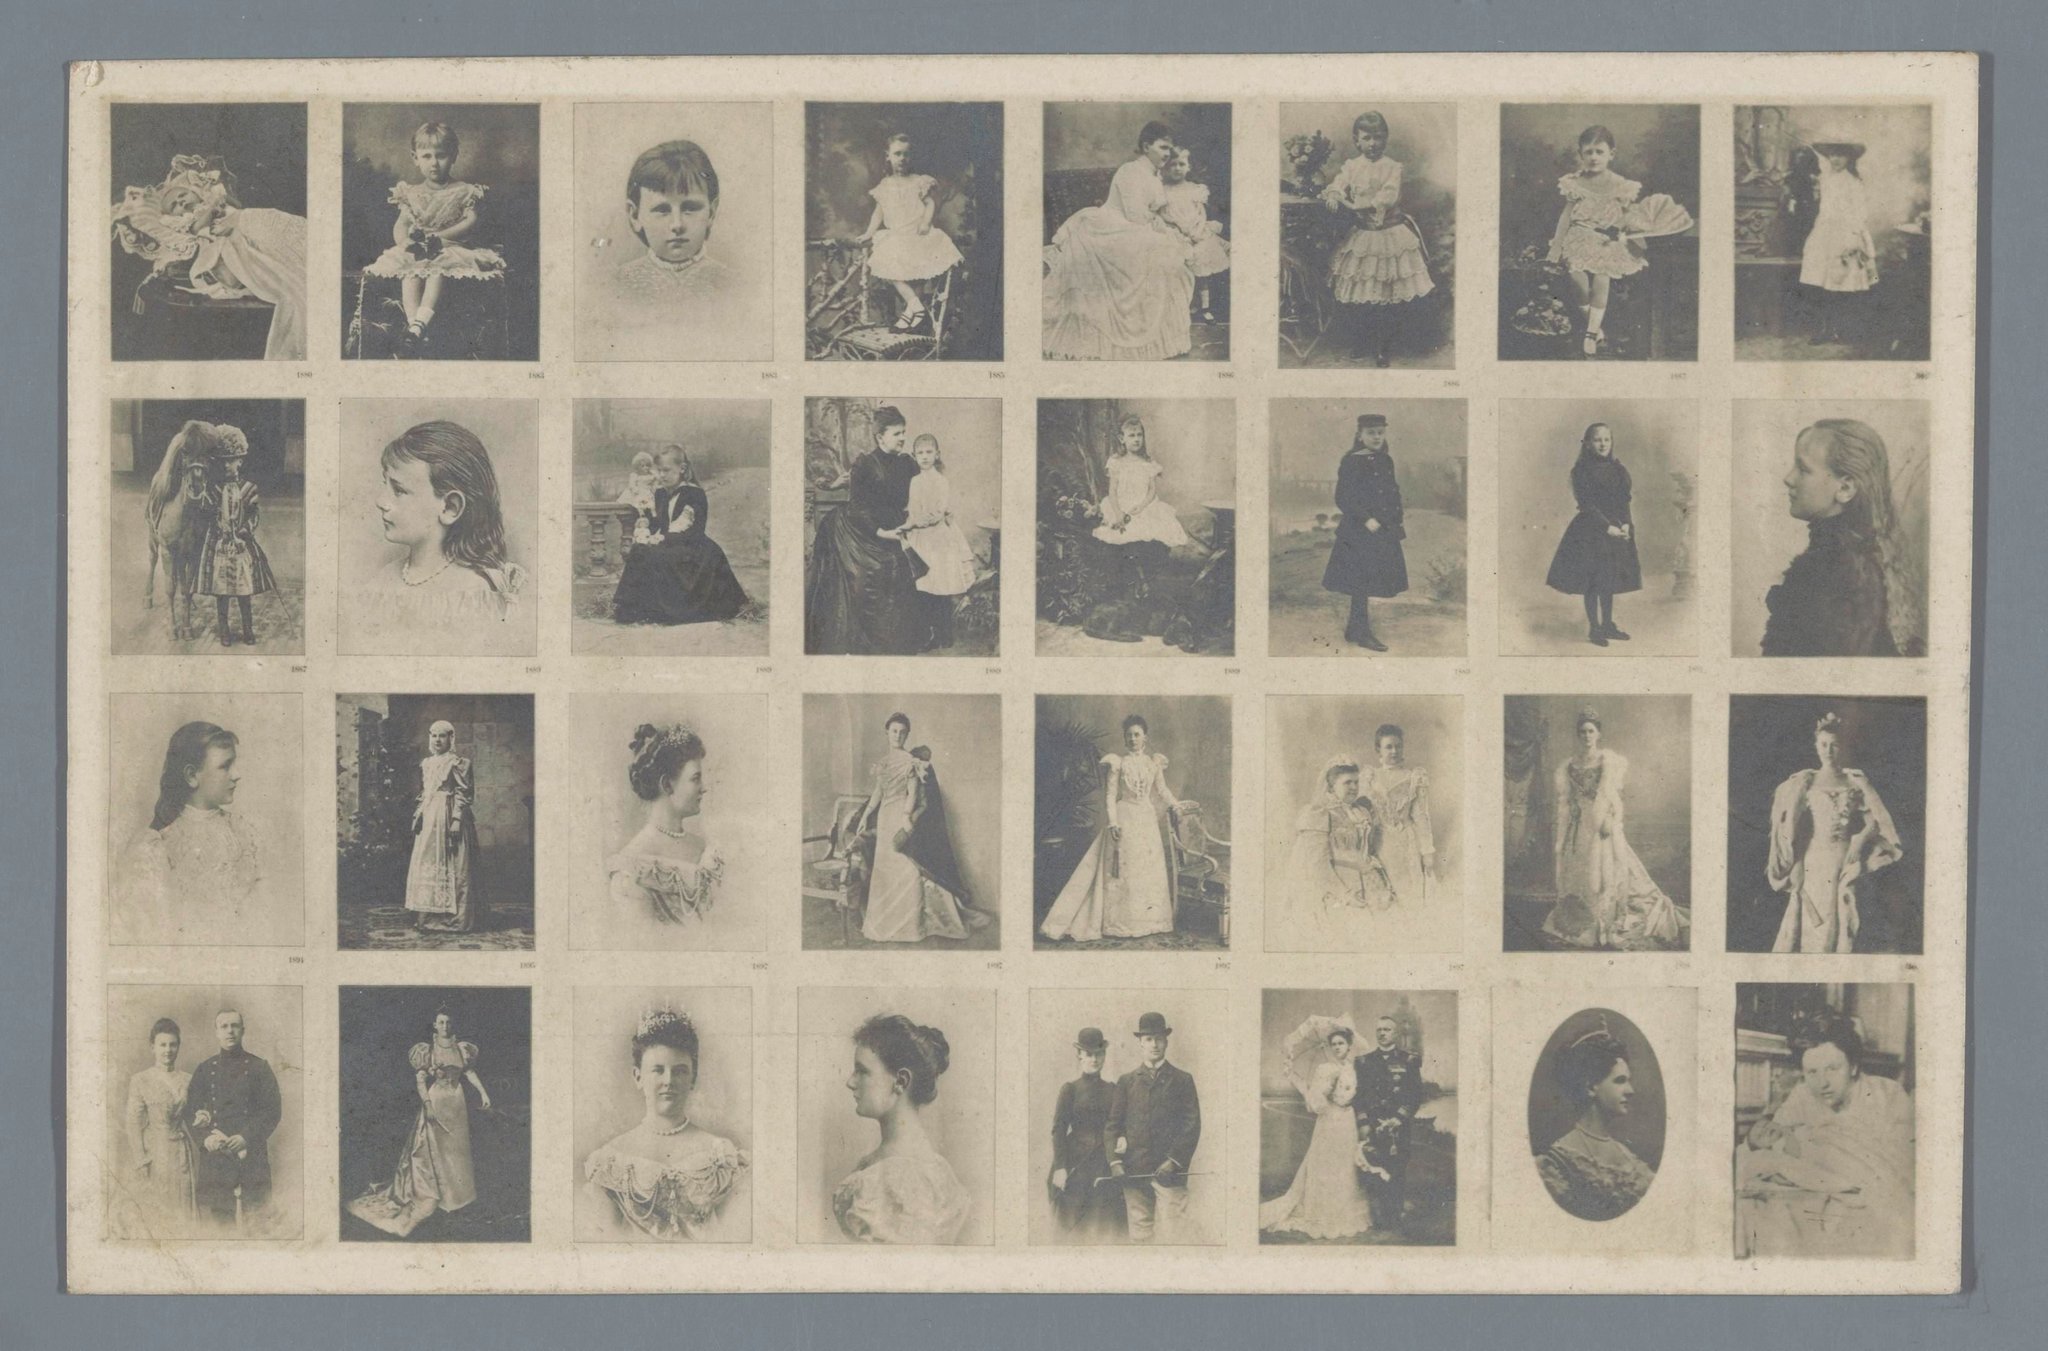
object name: photograph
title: H.M. koningin Wilhelmina 31 Aug. 1880 van kind tot moeder. 30 Apr. 1909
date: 1909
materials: photographic support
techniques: gelatin silver print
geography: netherlands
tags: the hague, print maker, wilhelmina of the netherlands, queen